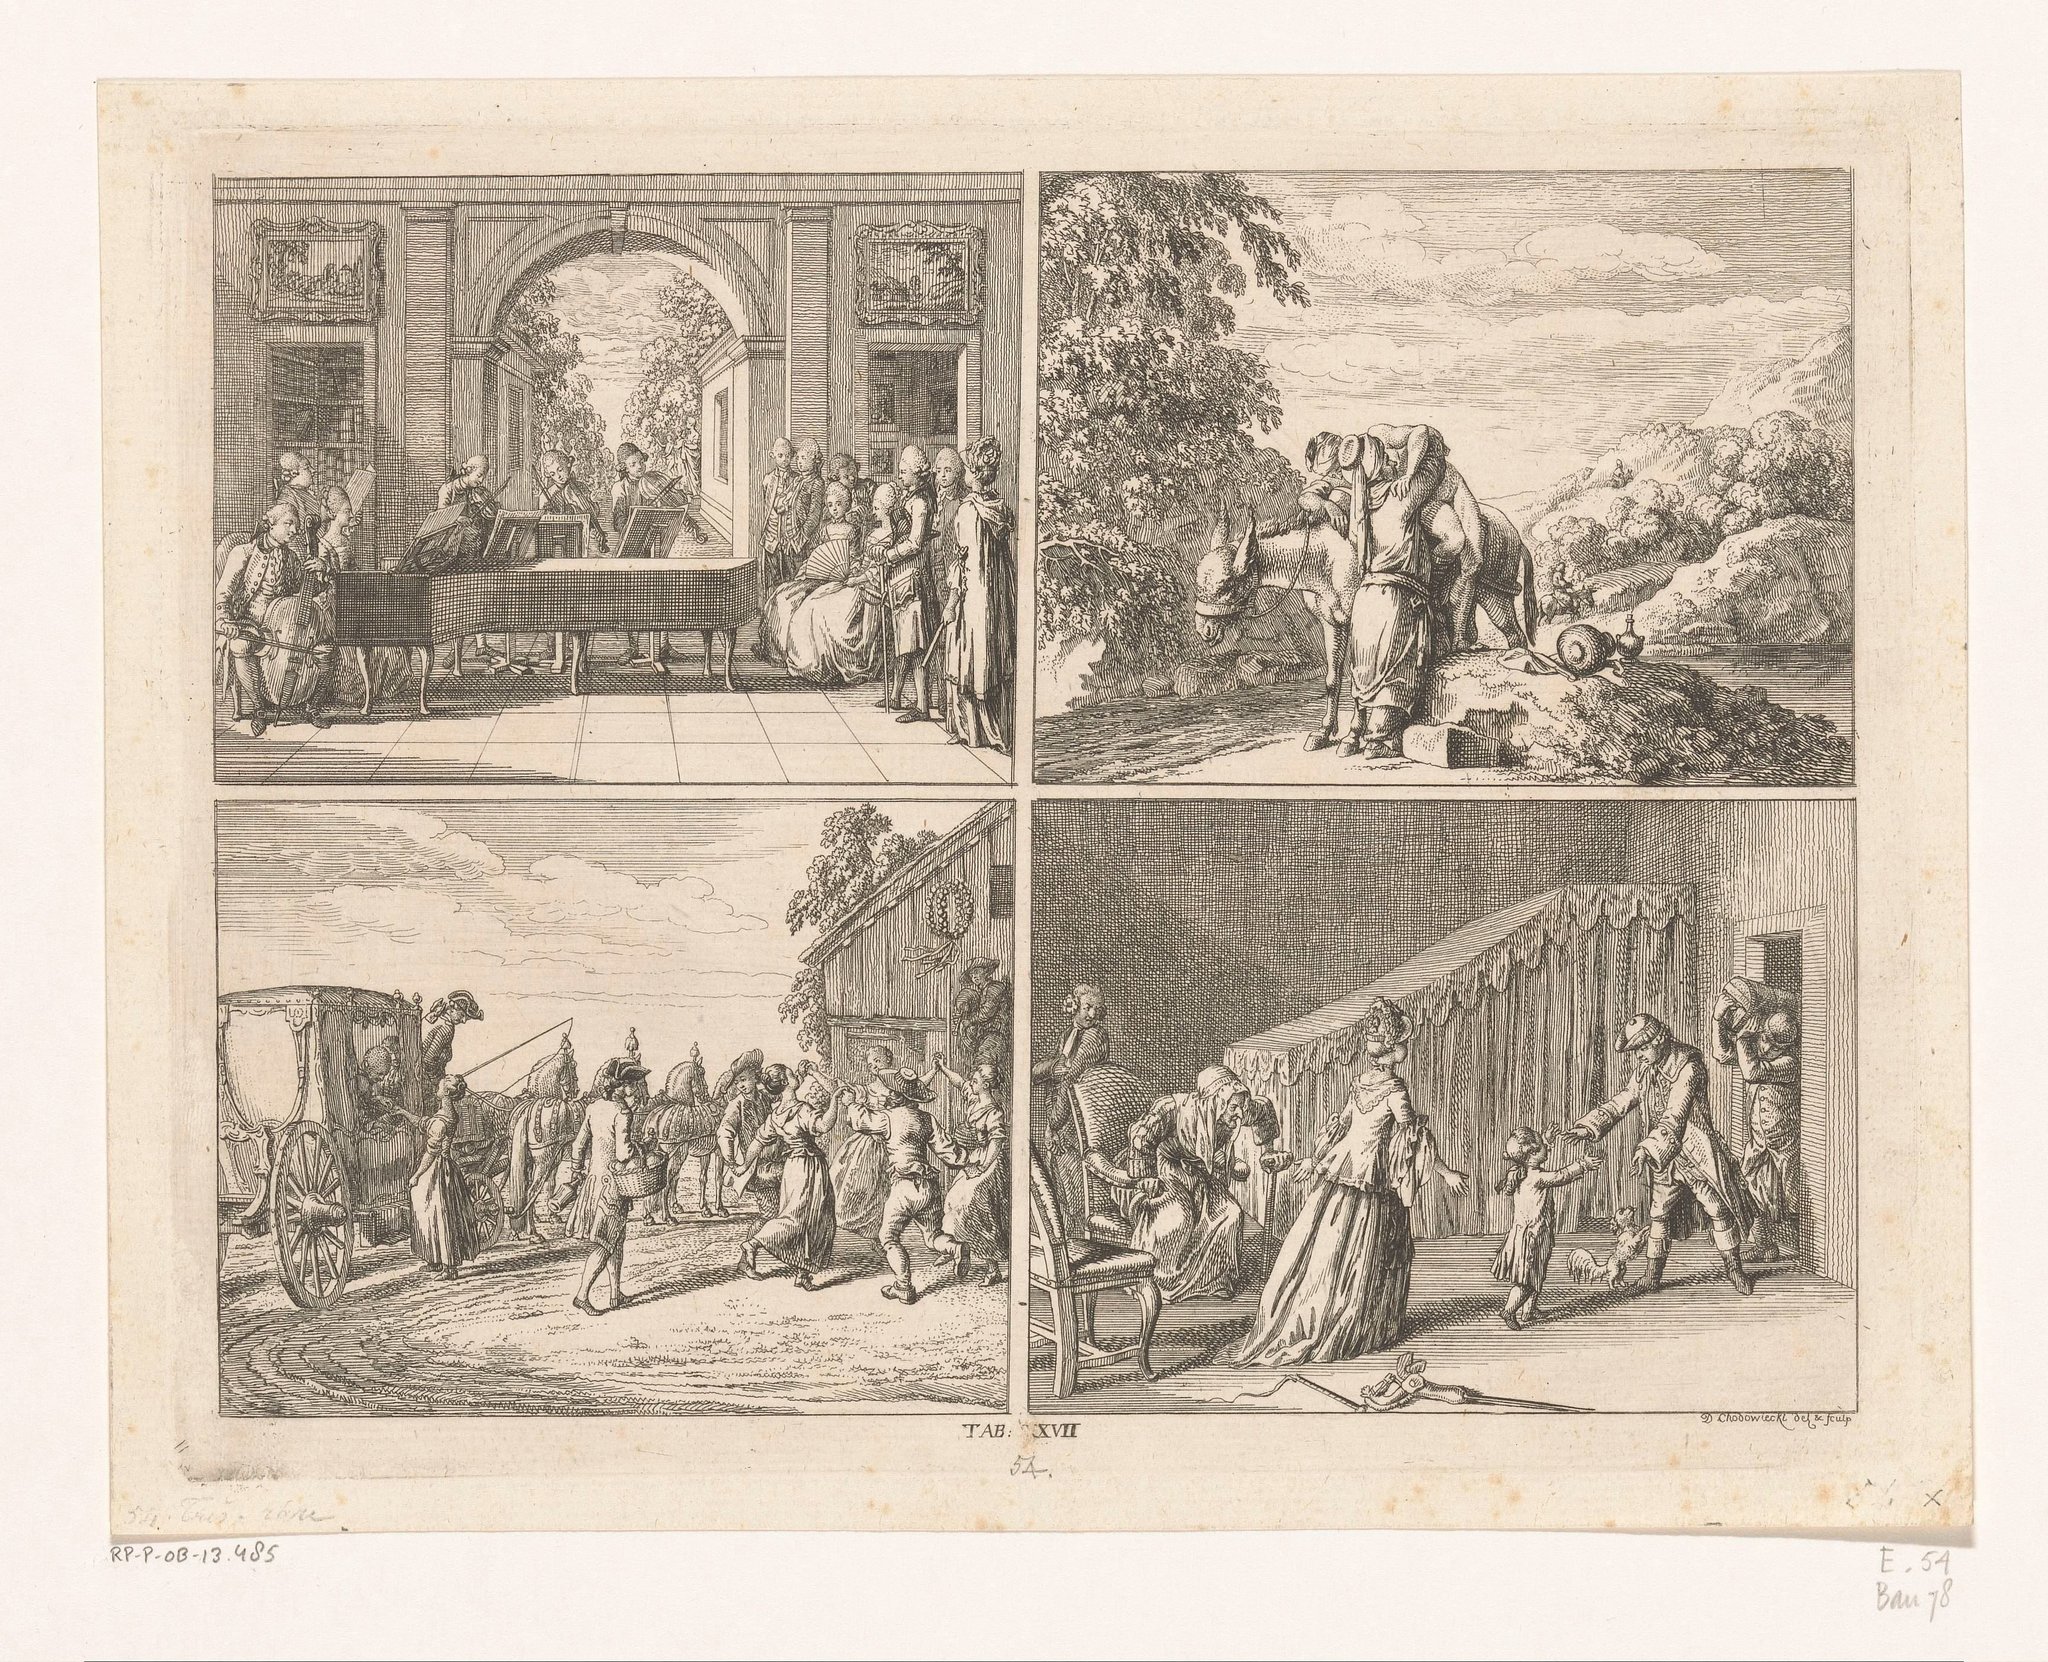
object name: print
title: Menselijke genoegens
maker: daniel nikolaus chodowiecki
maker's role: draughtsman, print maker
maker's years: 1726-1801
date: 1769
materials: paper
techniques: etching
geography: berlin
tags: johann bernhard basedow, making music; musician with instrument, the good samaritan (luke 10:30-37), folk dancing (men and women together), family, descendance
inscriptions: collector's mark: Lugt 2228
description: De prent maakt onderdeel uit van een serie van 96 prenten die verschenen ter illustratie van het 'Elementarwerk' van de Duitse pedagoog Johann Bernhard Basedow. De prenten werden door verschillende kunstenaars vervaardigd naar tekeningen van Daniel Chodowiecki. In 1774 verscheen het verzamelde prentwerk onder de titel: Kupfersammlung zu J.B. Basedows Elementarwerk für die Jugend und ihre Freunde.